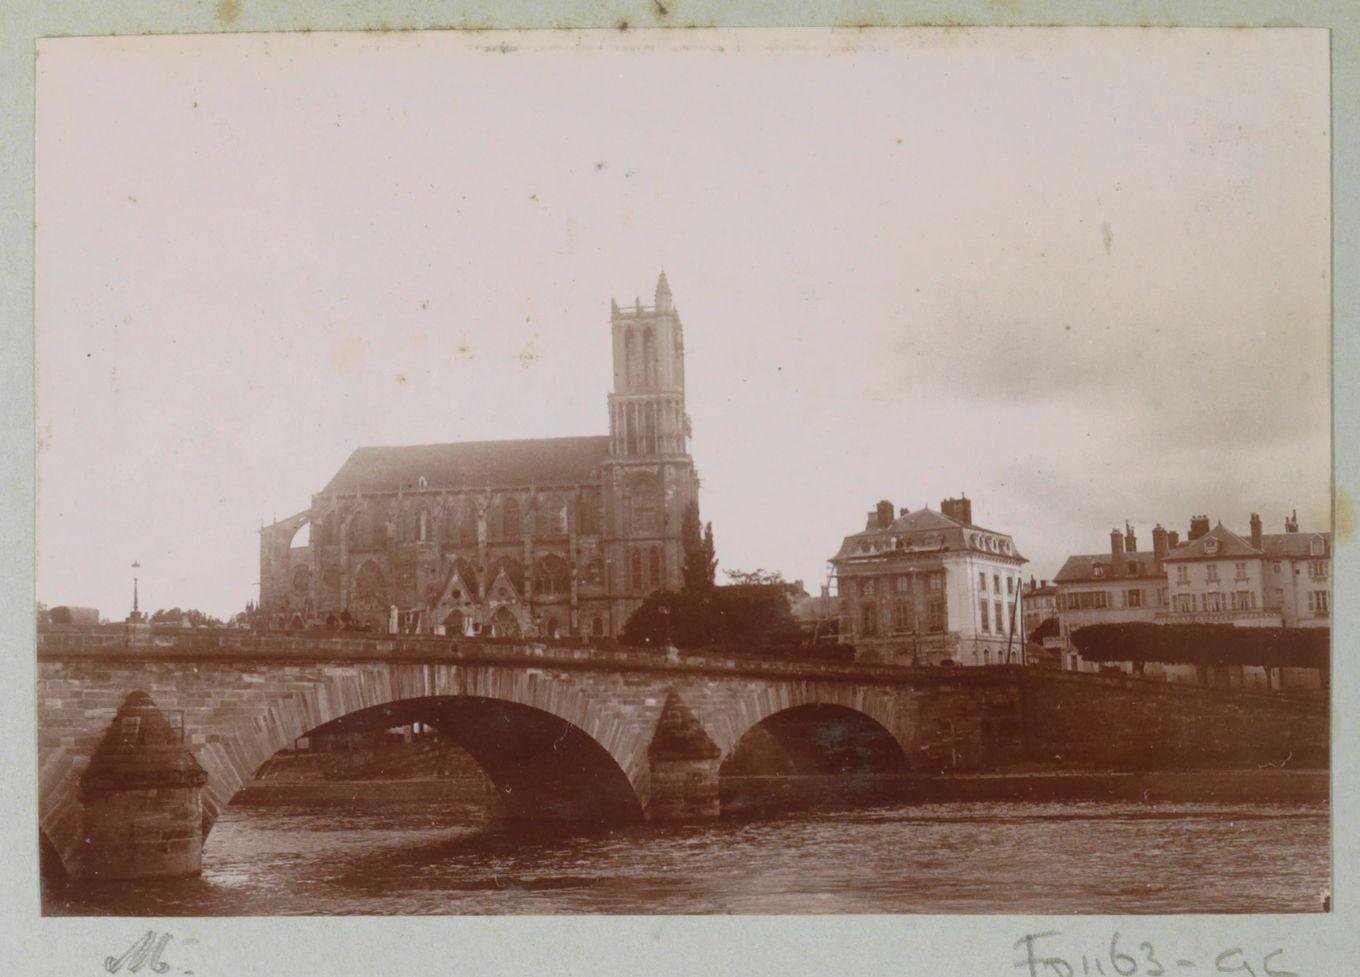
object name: photograph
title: Gezicht op Mantes-la-Jolie met de Notre Dame de Mantes en een brug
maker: delizy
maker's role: manufacturer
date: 1898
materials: paper, photographic support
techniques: gelatin silver print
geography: mantes-la-jolie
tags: prospect of village, silhouette of village, church (exterior), bridge in village across river, canal, etc.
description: Onderdeel van Fotoalbum van een Franse amateurfotograaf met opnames van uitstapjes in Frankrijk, Spanje, België, Luxemburg en Nederland, de eerste automobielen en autoraces.